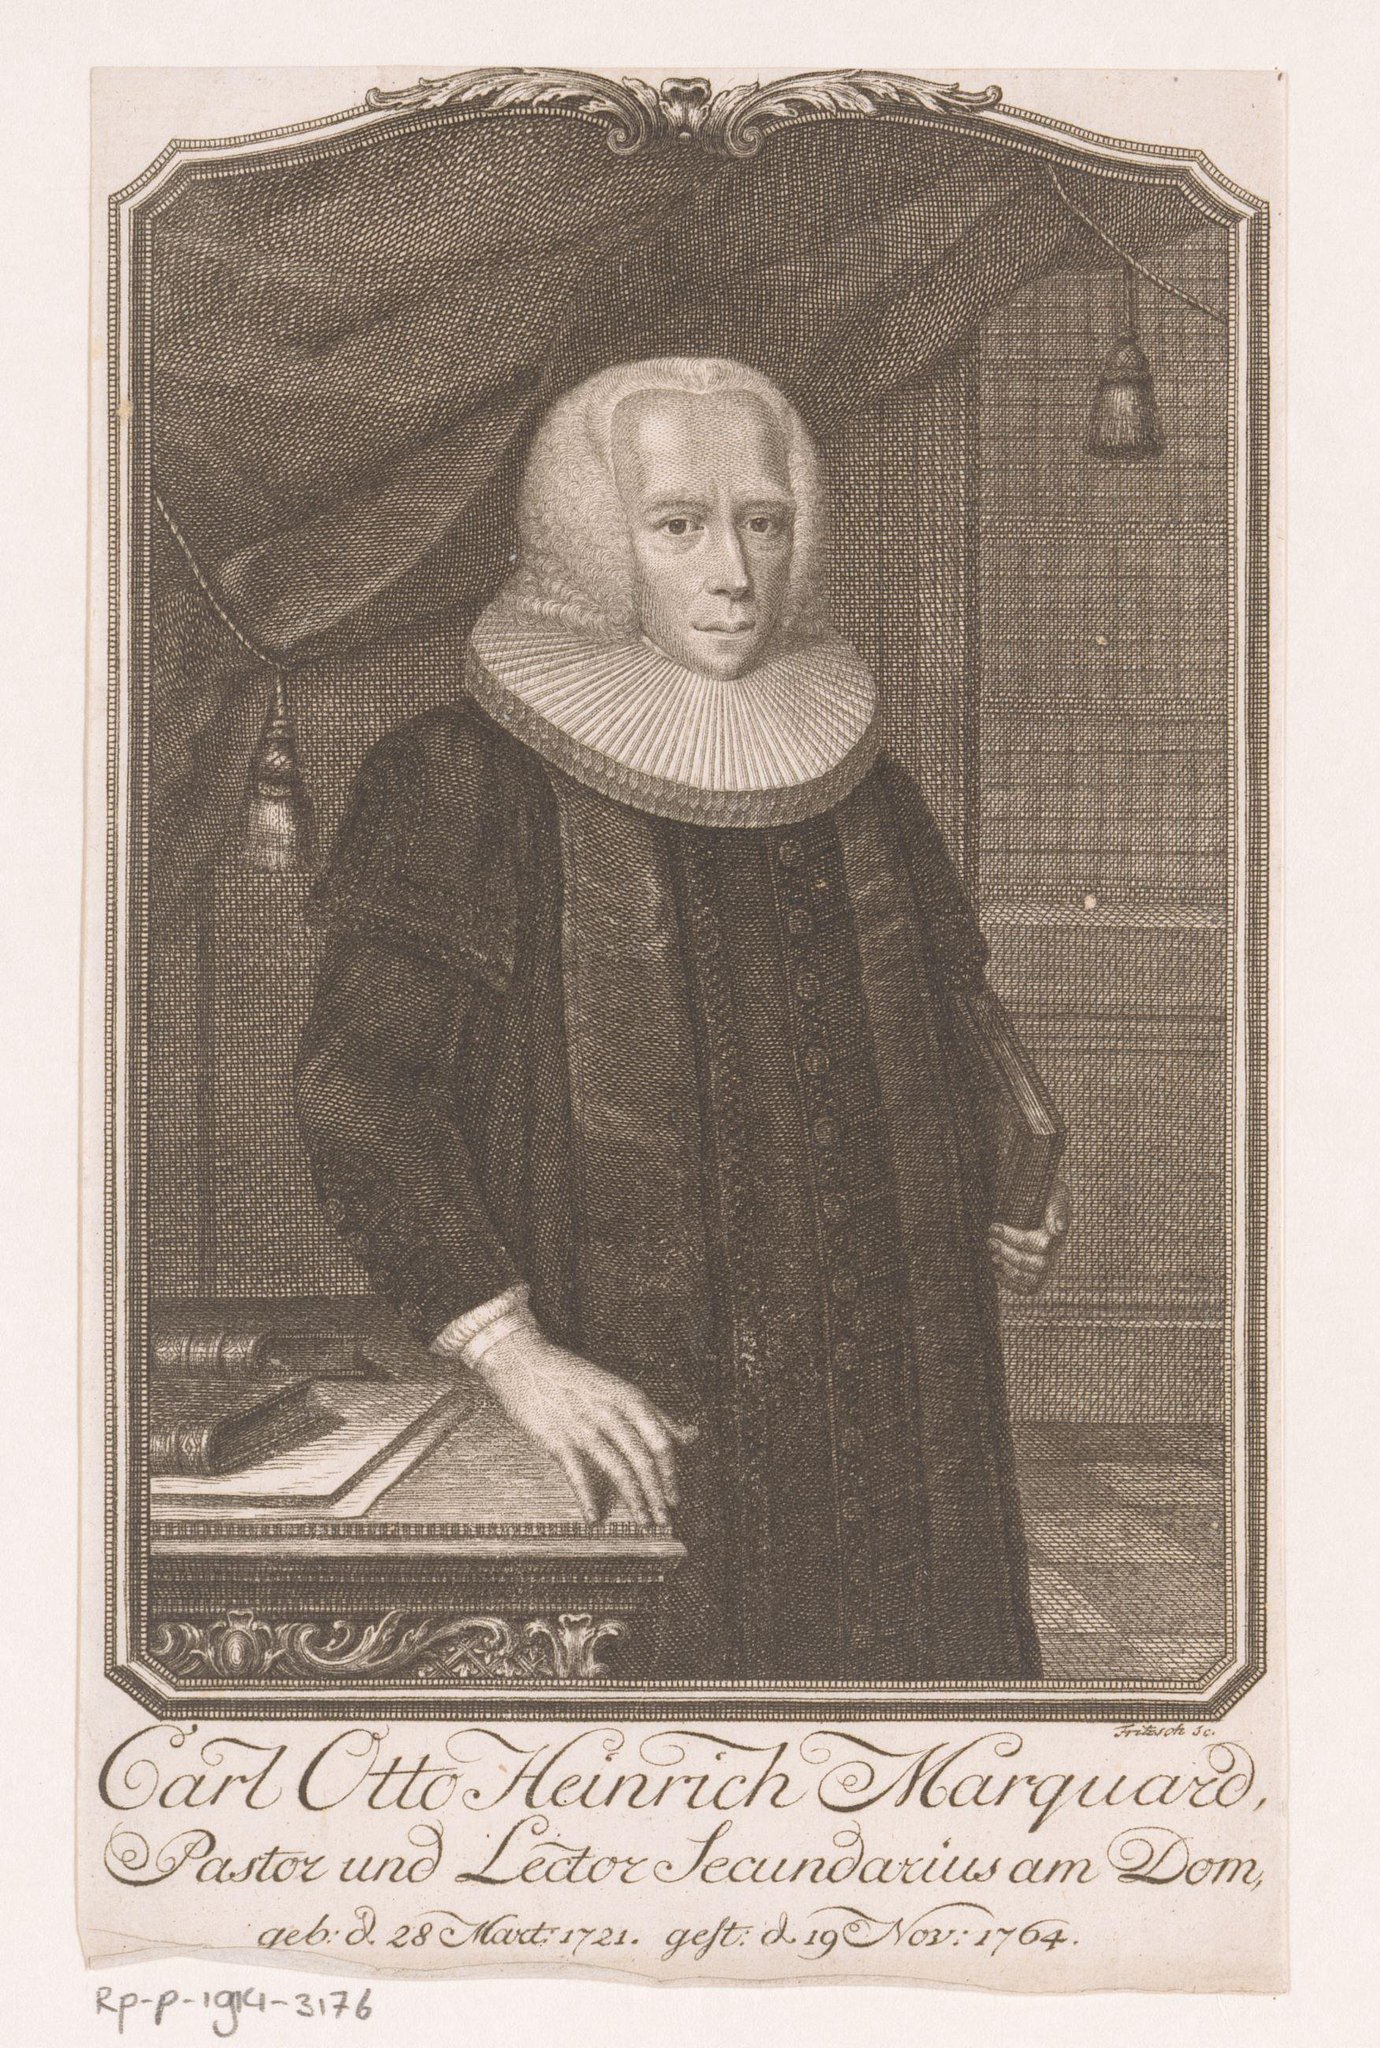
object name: print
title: Portret van Karl Otto Heinrich Marquard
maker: johann christian gottfried fritzsch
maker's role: print maker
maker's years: 1720-1802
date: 1764-1802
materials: paper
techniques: engraving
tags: bookshelves, historical persons, book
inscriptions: collector's mark: Lugt 2228